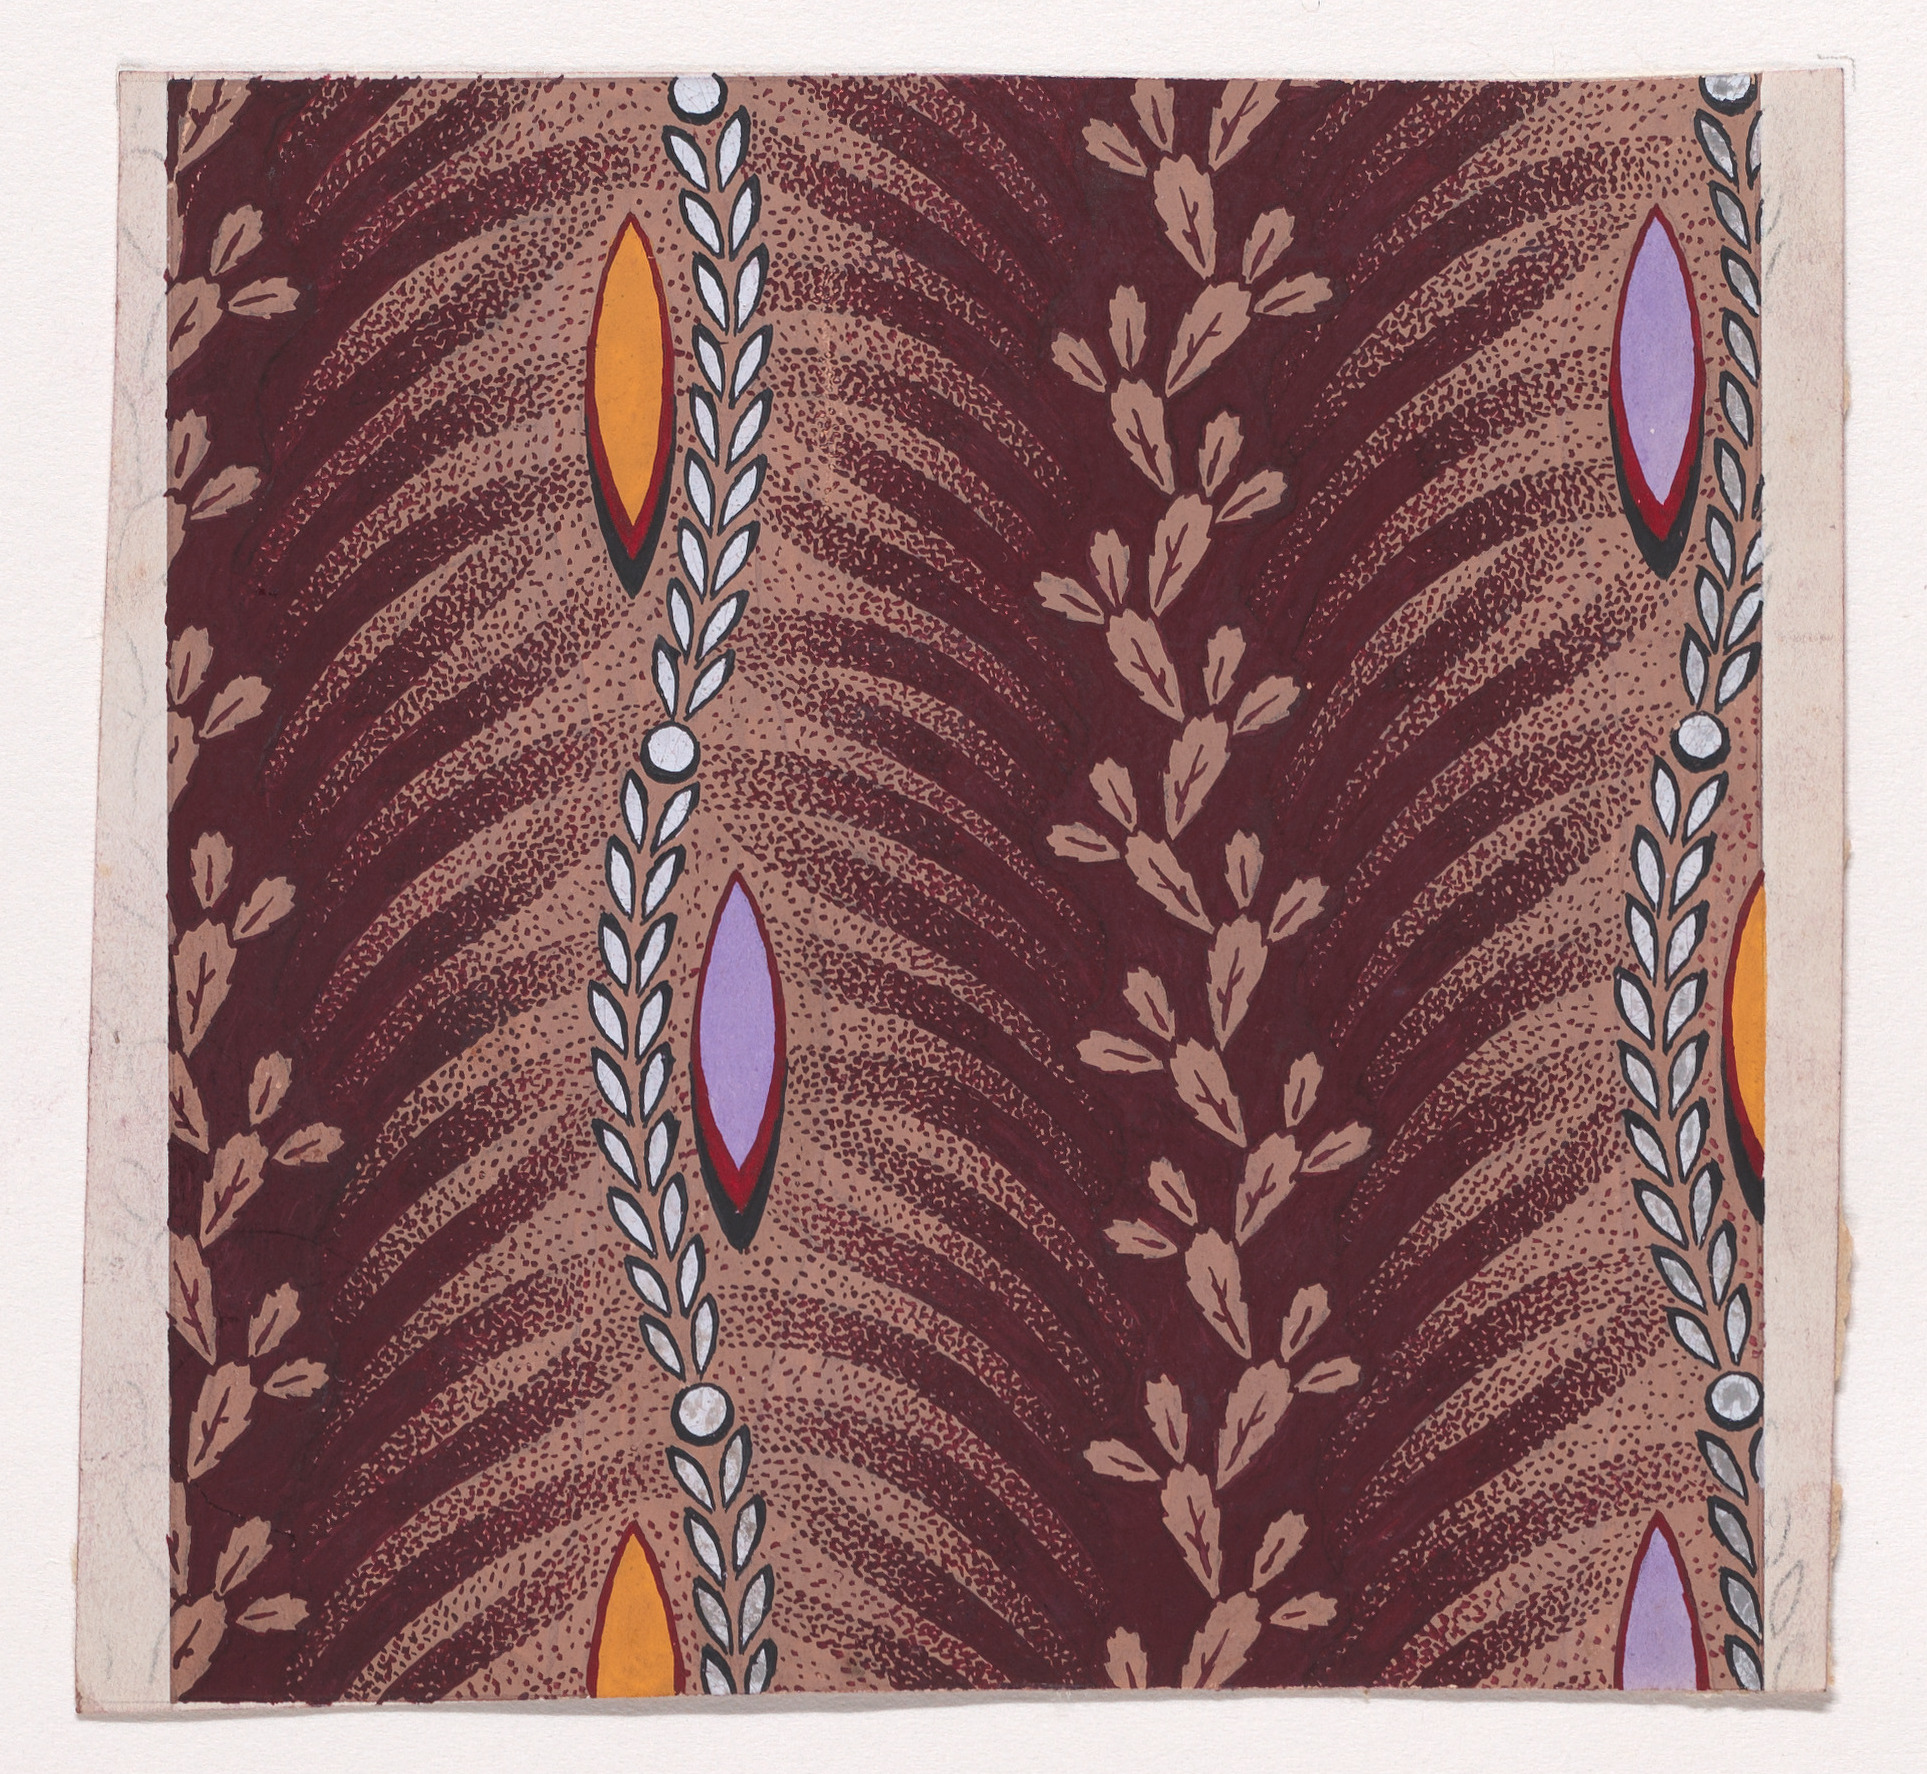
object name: drawing ornament architecture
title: Textile Design with Vertical Undulating Garlands of Stylized Leaves with Offsetting Stylized Palm Leaves Separated by Vertical Undulating Garlands of Leaves and Pearls with Alternating Shuttle-Shaped Motifs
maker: anonymous, alsatian, 19th century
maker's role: artist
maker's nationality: alsatian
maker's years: 1800-1900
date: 1840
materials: gouache